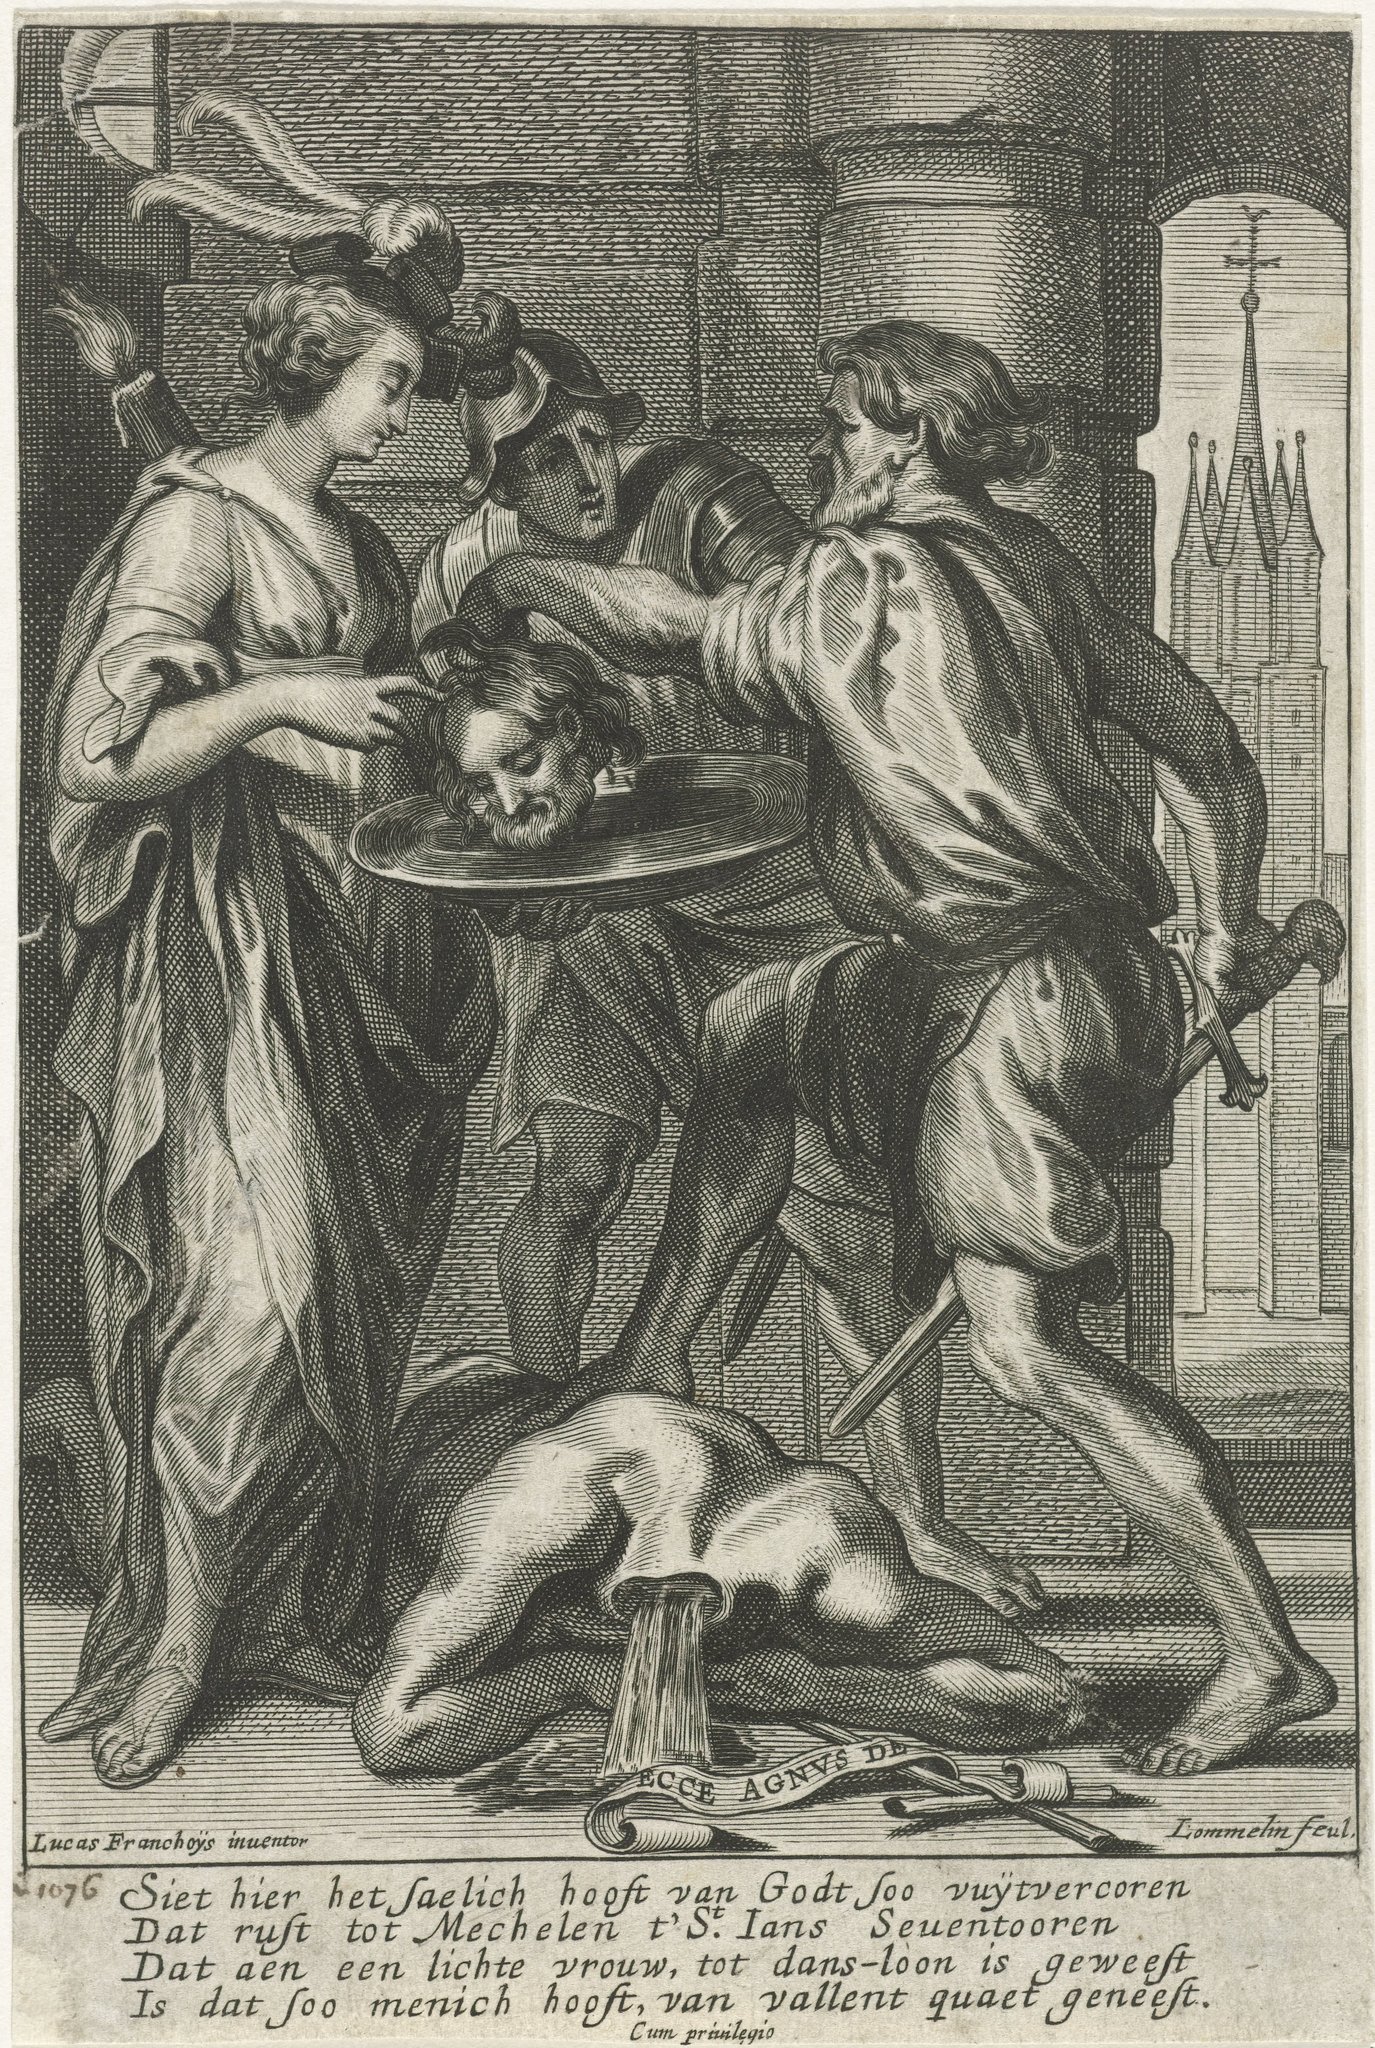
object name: print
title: Onthoofding van Johannes de Doper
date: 1630-1677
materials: paper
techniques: engraving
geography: antwerp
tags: salome is given the head of john the baptist by the executioner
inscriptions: collector's mark: Lugt 2228, collector's mark: Lugt 1337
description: Een beul legt het hoofd van Johannes de Doper op een schaal die Salome vasthoudt. Het onthoofde lichaam van Johannes ligt voor haar op de grond. In de marge een vierregelige tekst in het Nederlands.